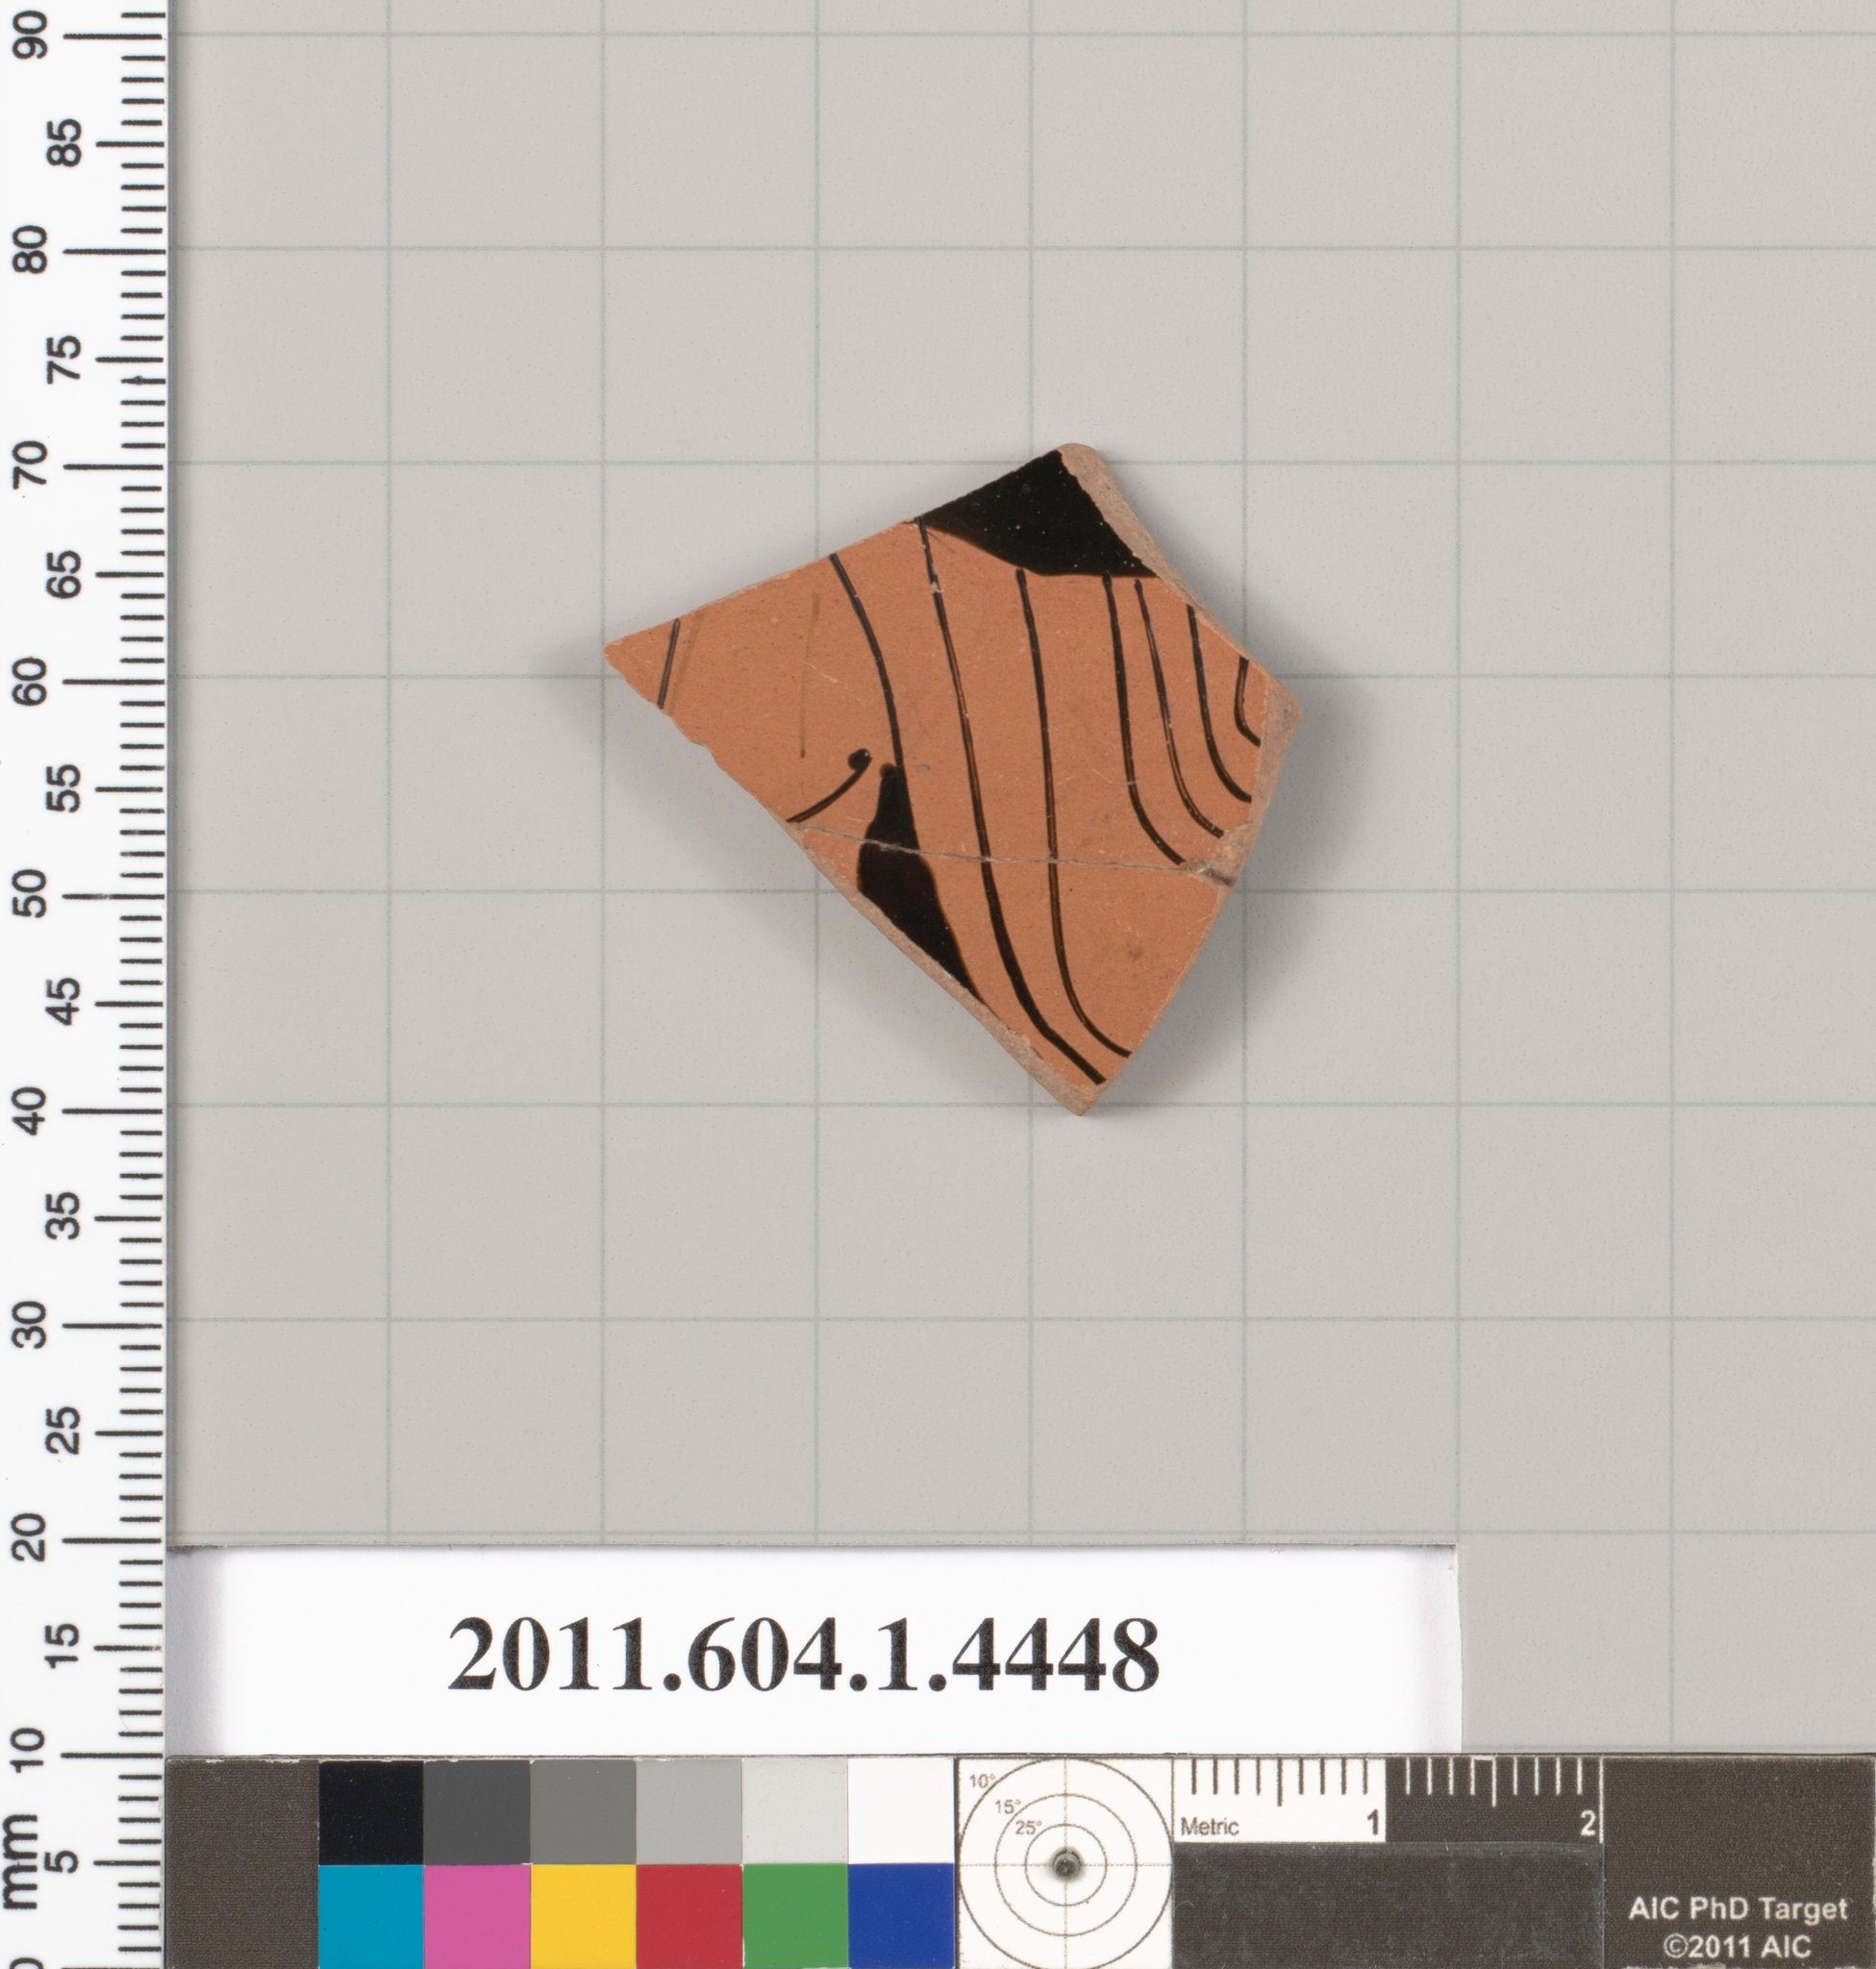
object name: kylix fragment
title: Terracotta fragment of a kylix (drinking cup)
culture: greek, attic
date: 490-470 BCE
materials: terracotta